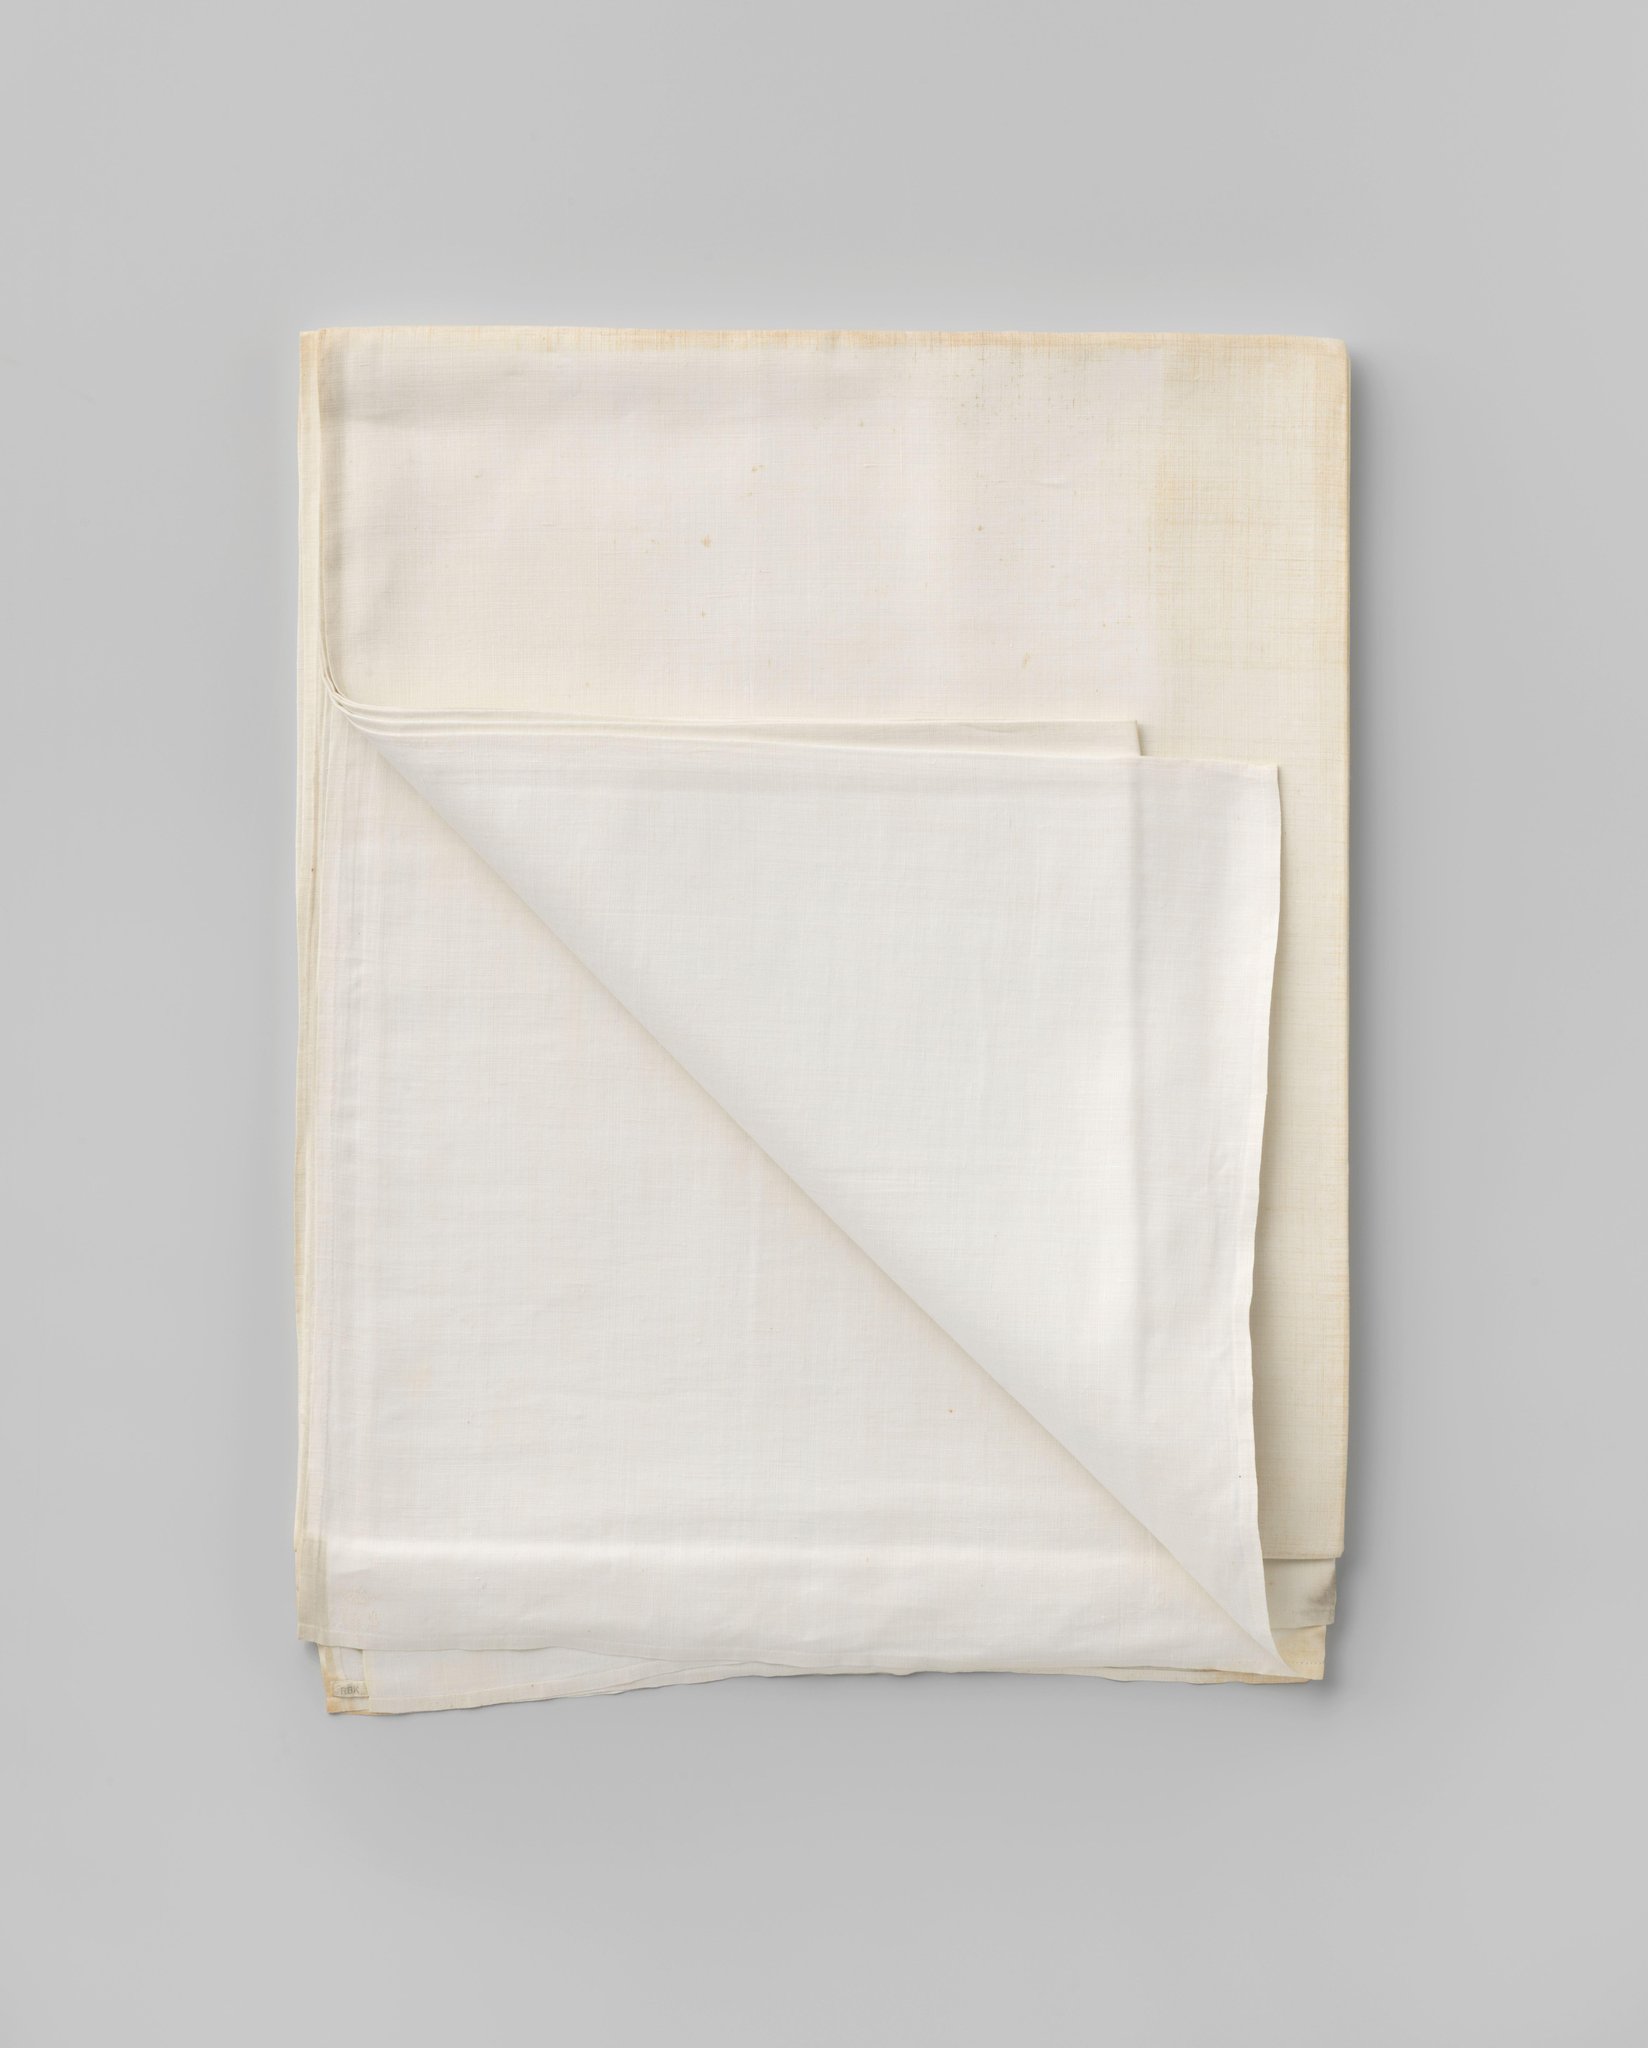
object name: beddenlaken, laken object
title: Laken. Merk: kroon IIVG.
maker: Anonymous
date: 1692-1735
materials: linen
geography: northern netherlands